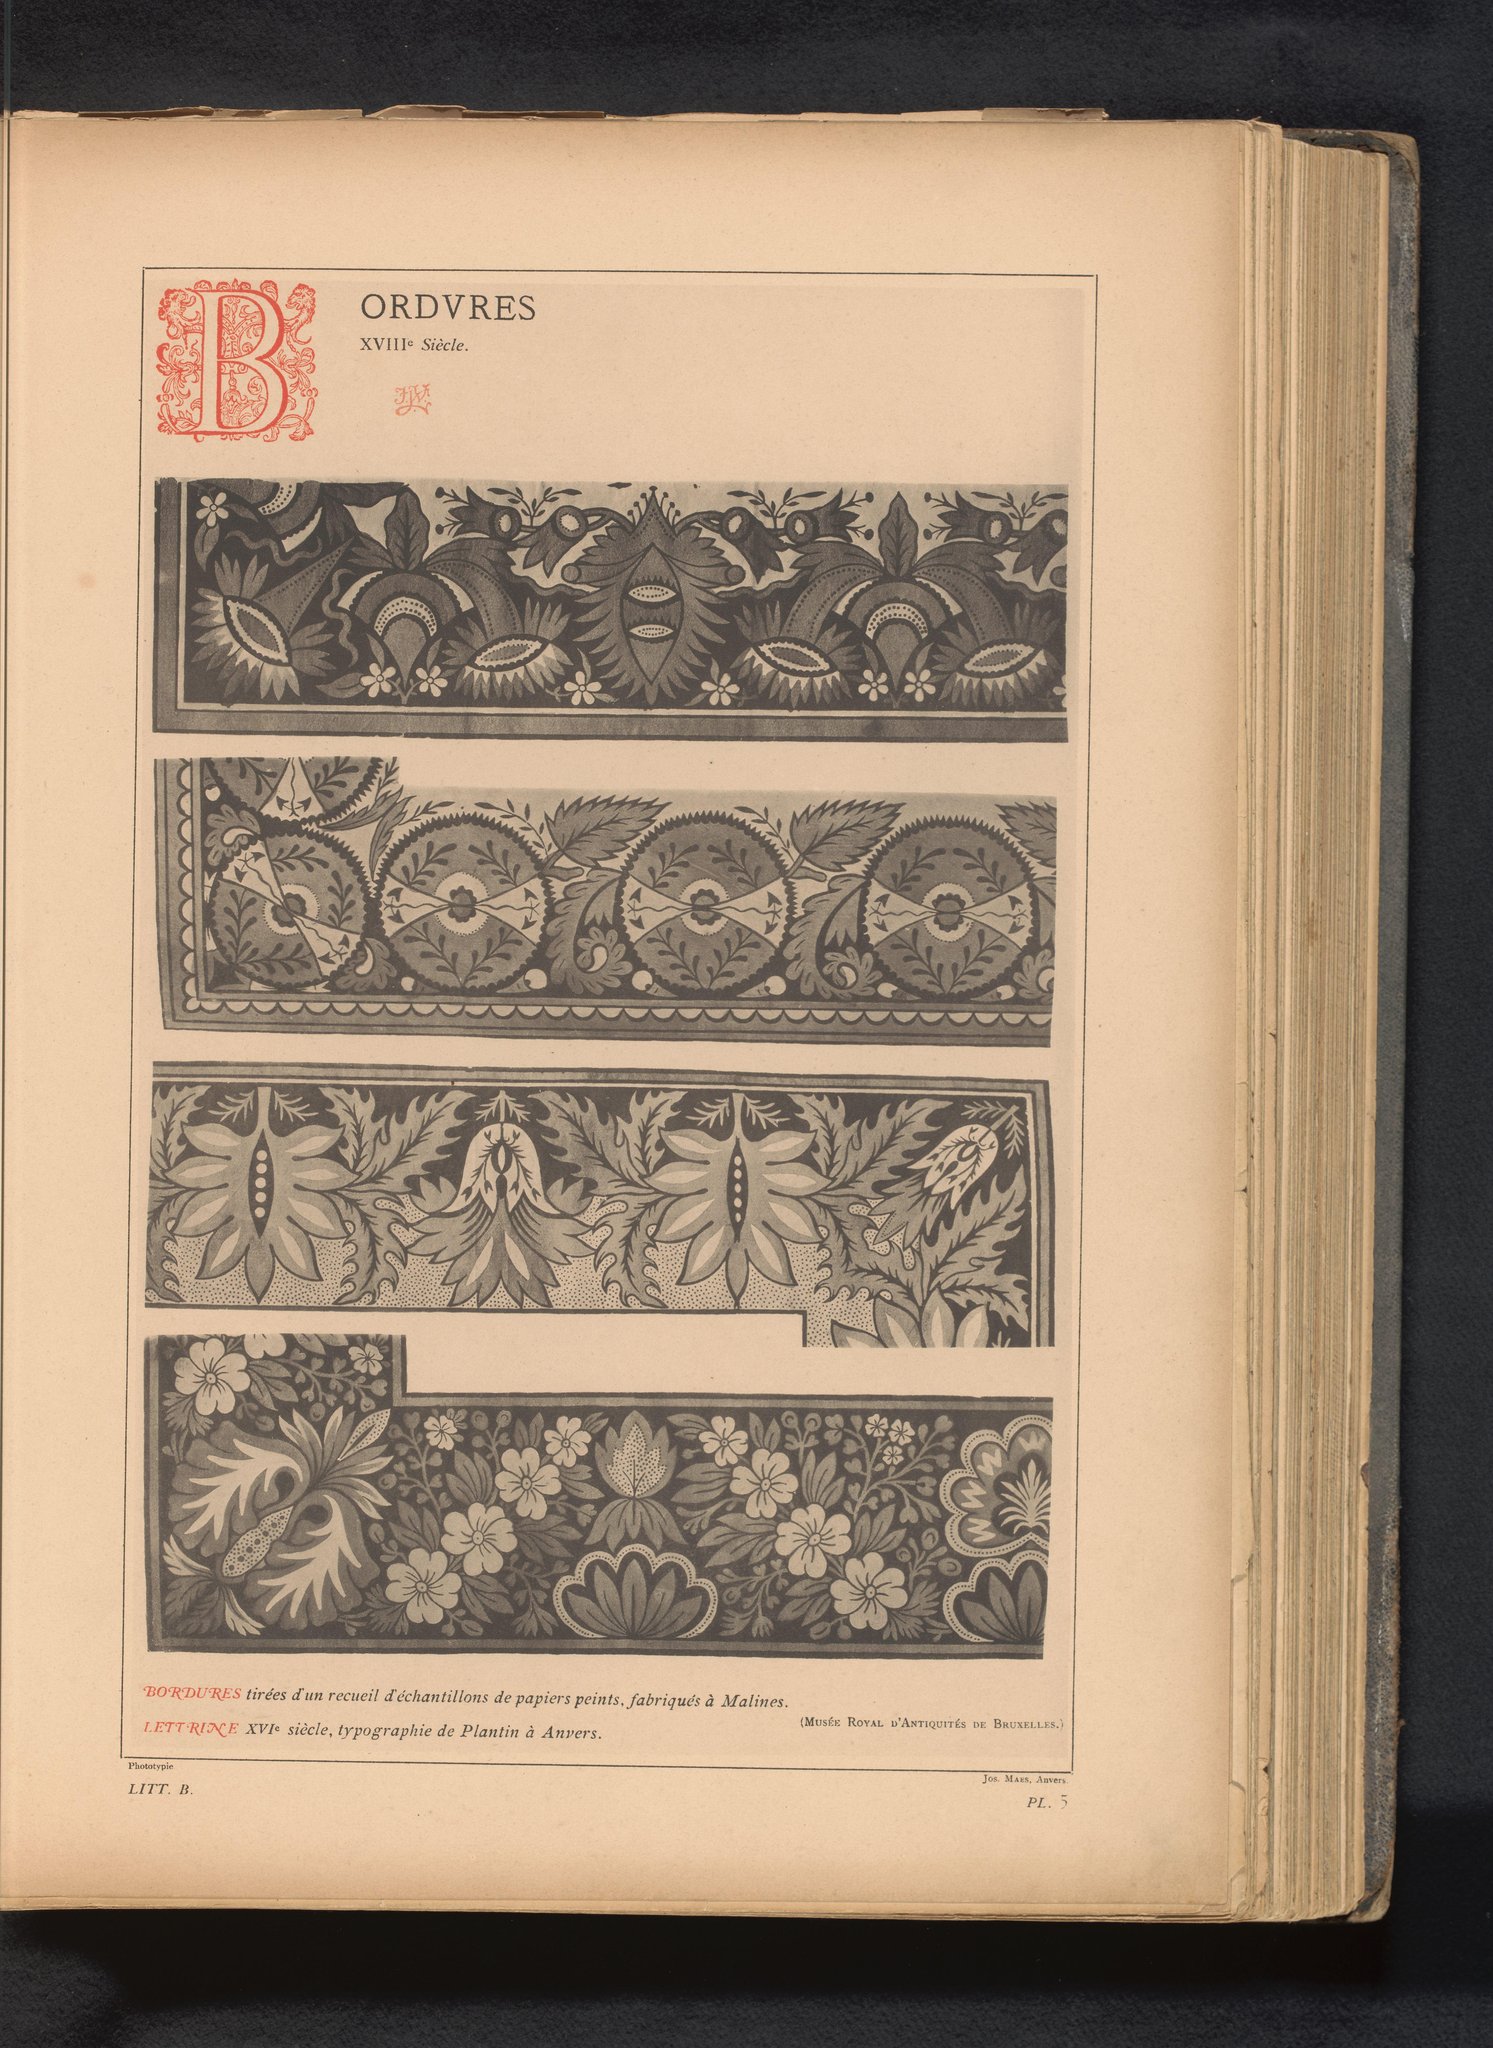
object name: photomechanical print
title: Bordures, XVIIIe Siècle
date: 1875-1880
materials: paper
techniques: photograph, photolithography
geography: antwerp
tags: embroidering ~ textile industry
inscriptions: monogram: ‘JJvY’, inscription: ‘LITT. B. - PL. 5’, inscription: ‘Bordures tirées d'un (...)’